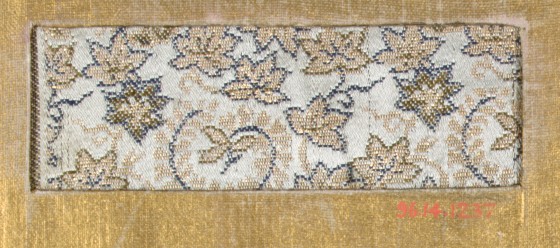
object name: piece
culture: japanese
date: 1701-1900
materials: silk